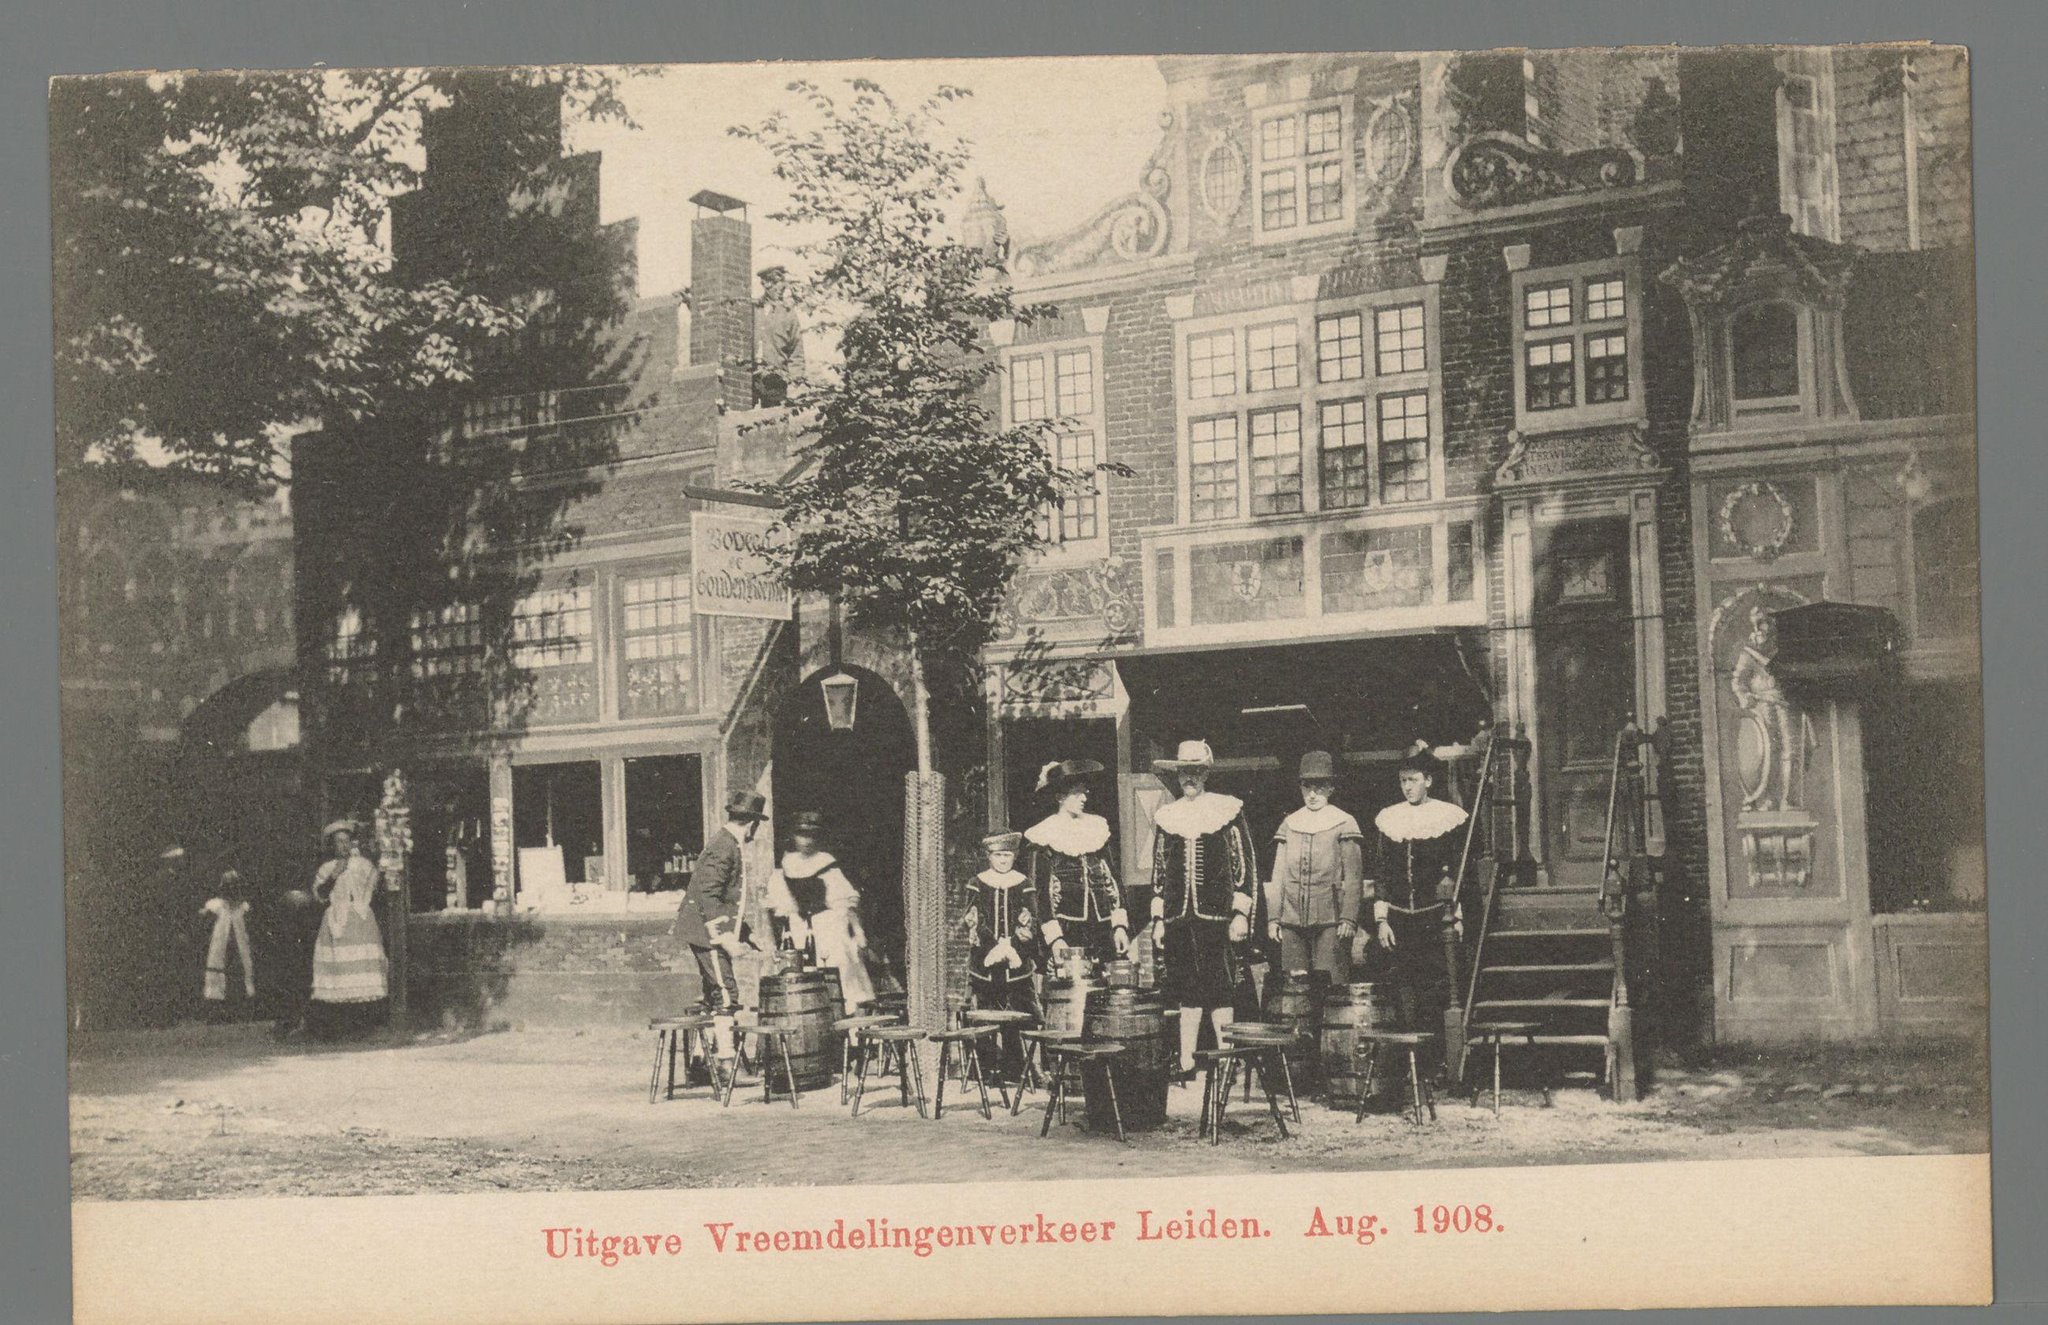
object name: ansichtkaart, prentbriefkaart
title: Mensen in kostuum voor een café tijdens de Oud-Hollandse feesten te Leiden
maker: Anonymous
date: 1908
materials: cardboard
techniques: photograph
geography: leiden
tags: wooden container: barrel, cask, bucket, dress-up party, inn, coffee-house, public house, etc., festivities, leiden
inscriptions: date